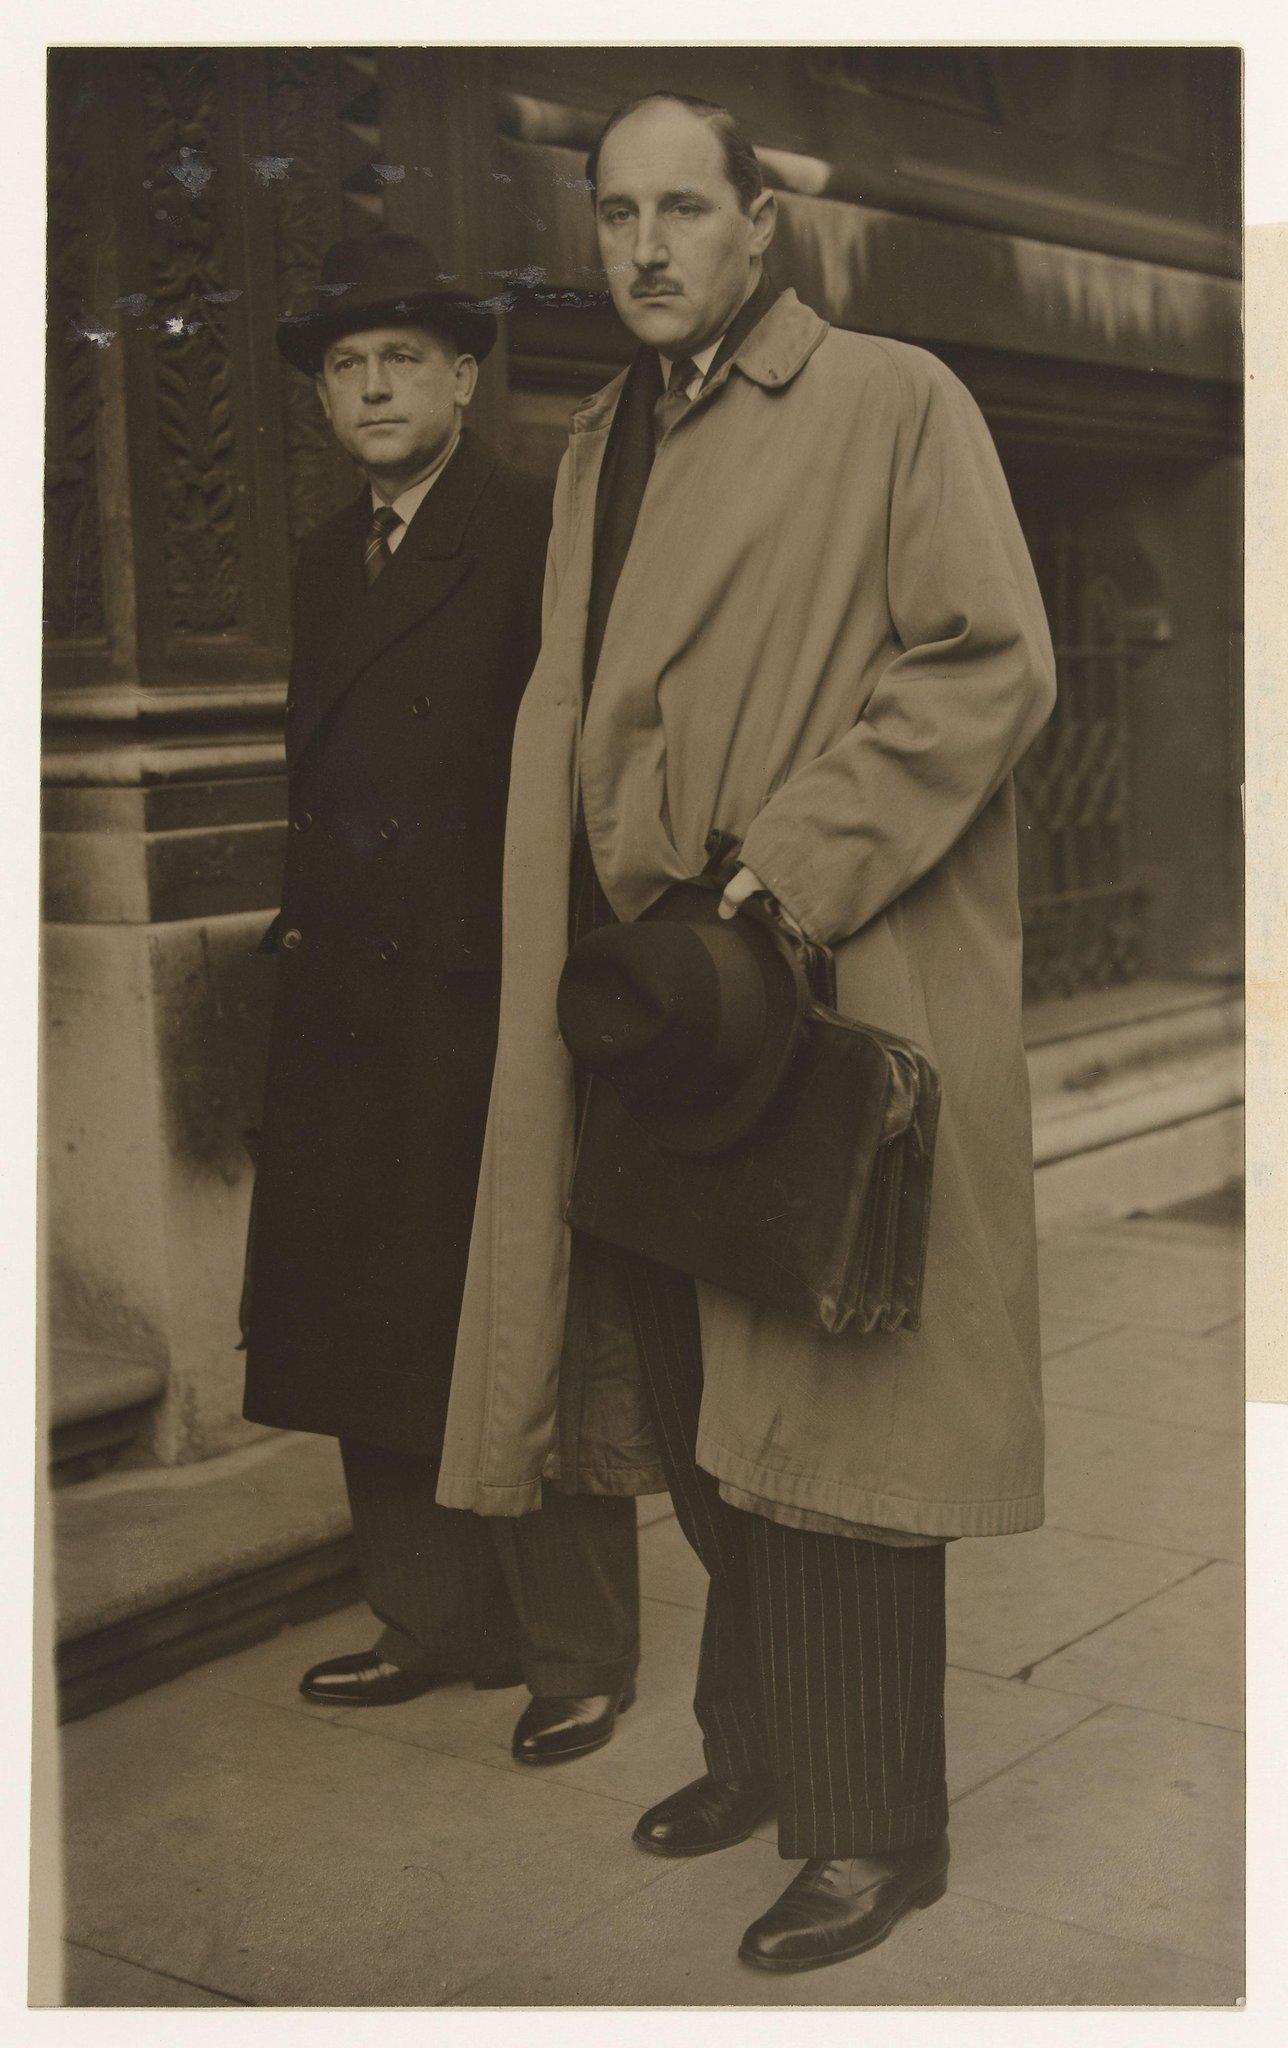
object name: documentary photograph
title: Luns en De Vooys arriveren voor Zesmogendhedenconferentie te Londen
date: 1949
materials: photographic support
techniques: photography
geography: london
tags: rotterdam, brussels, publisher, london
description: Luns, ambassade-secretaris te Londen en De Vooys, technisch adviseur voor de Nederlandse ambassade staan voor de drempel van het Foreign Office voor een conferentie over de toekomst van het Ruhrgebied. De Zesmogendhedenconferentie, met als deelnemende landen: België, Frankrijk, Luxemburg, Groot-Brittannië, de Verenigde Staten en Nederland, kwam bijeen van 11 november tot 28 december 1949 om maatregelen te nemen tot deconcentratie van de Ruhrindustrie, voornamelijk met de bedoeling de wapenindustire te controleren. Uiteindelijk wordt er besloten tot het zogenaamde Ruhrstatuut met als belangrijkste wapenfeit het instellen van een internationaal controle-orgaan om toekomstige agressie te voorkomen en de wederopbouw en economische samenwerking in West-Europa te bevorderen.